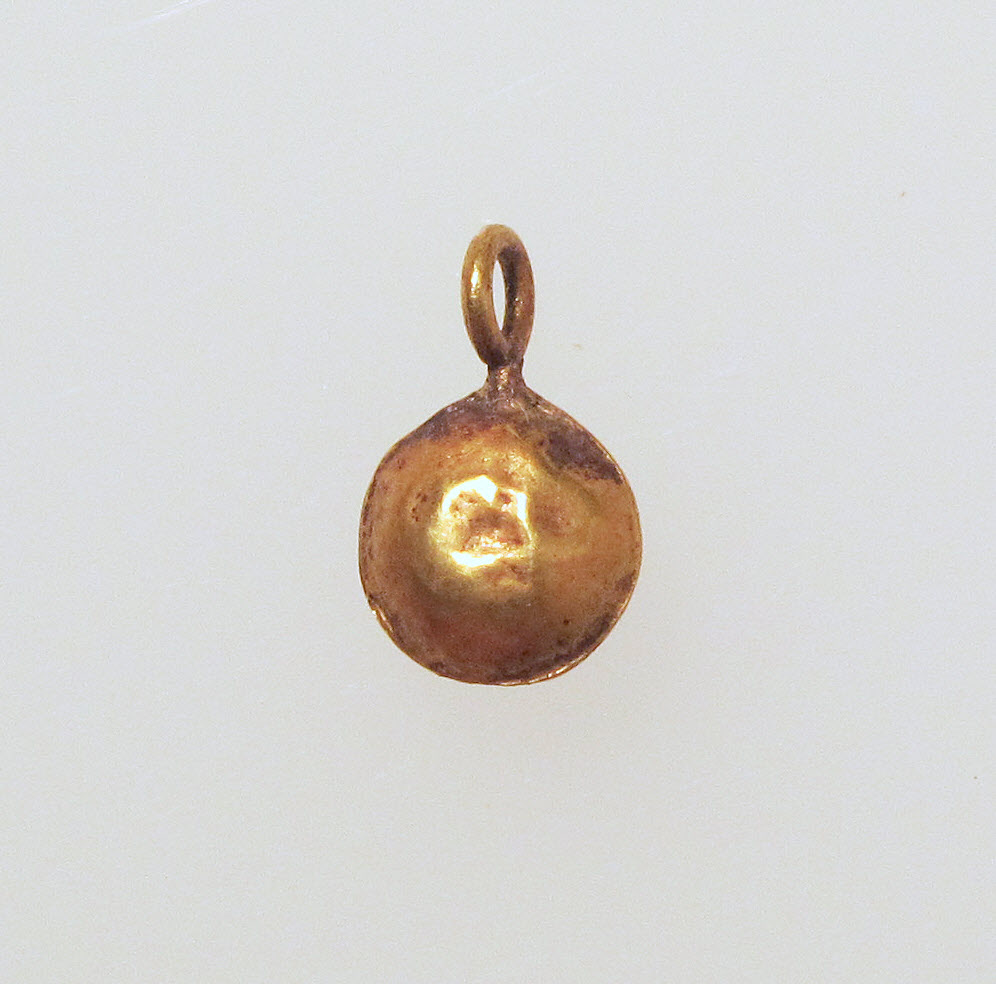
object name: pendant, lentoid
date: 7000 BCE-330 CE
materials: gold